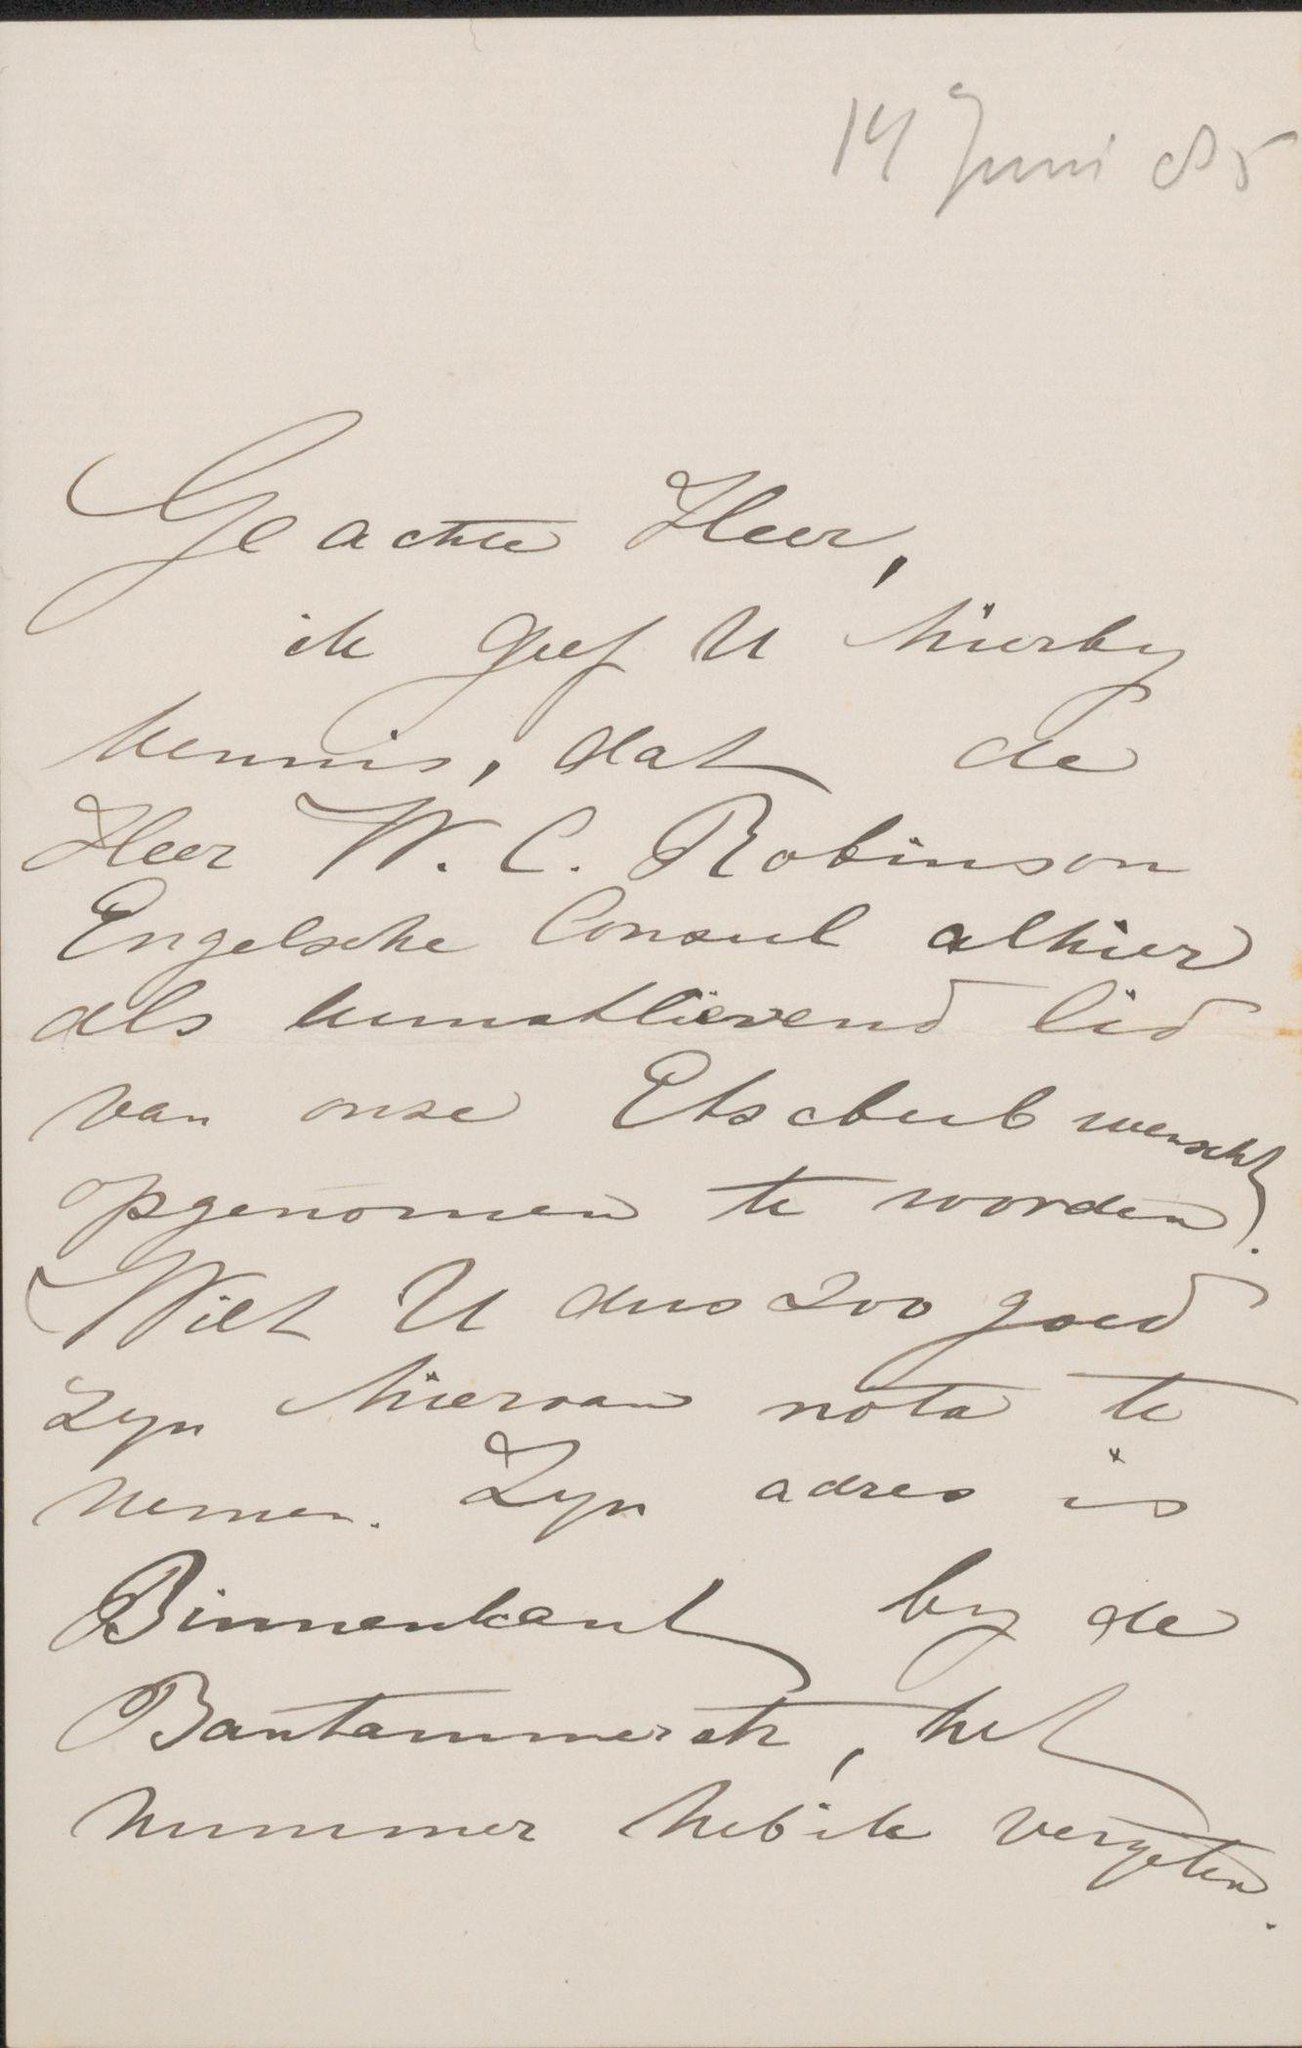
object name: letter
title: Brief aan Jan Veth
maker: wally moes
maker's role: draughtsman, print maker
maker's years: 1856-1918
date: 1885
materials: ink, paper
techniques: pen, writing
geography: amsterdam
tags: dordrecht, painter, designer, jan veth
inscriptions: collector's mark: ‘RPK’, watermark